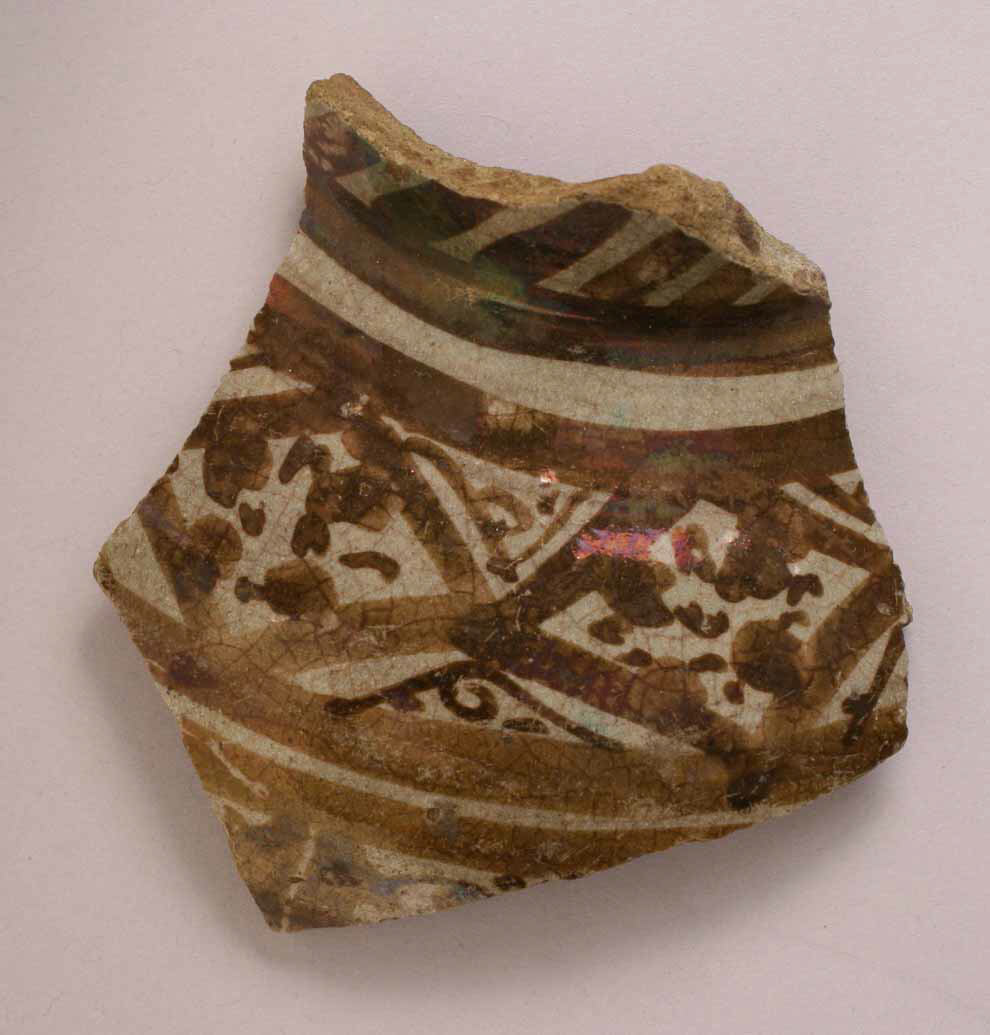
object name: ceramic fragment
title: Fragment of a Dish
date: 1001-1200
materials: earthenware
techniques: luster painting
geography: egypt